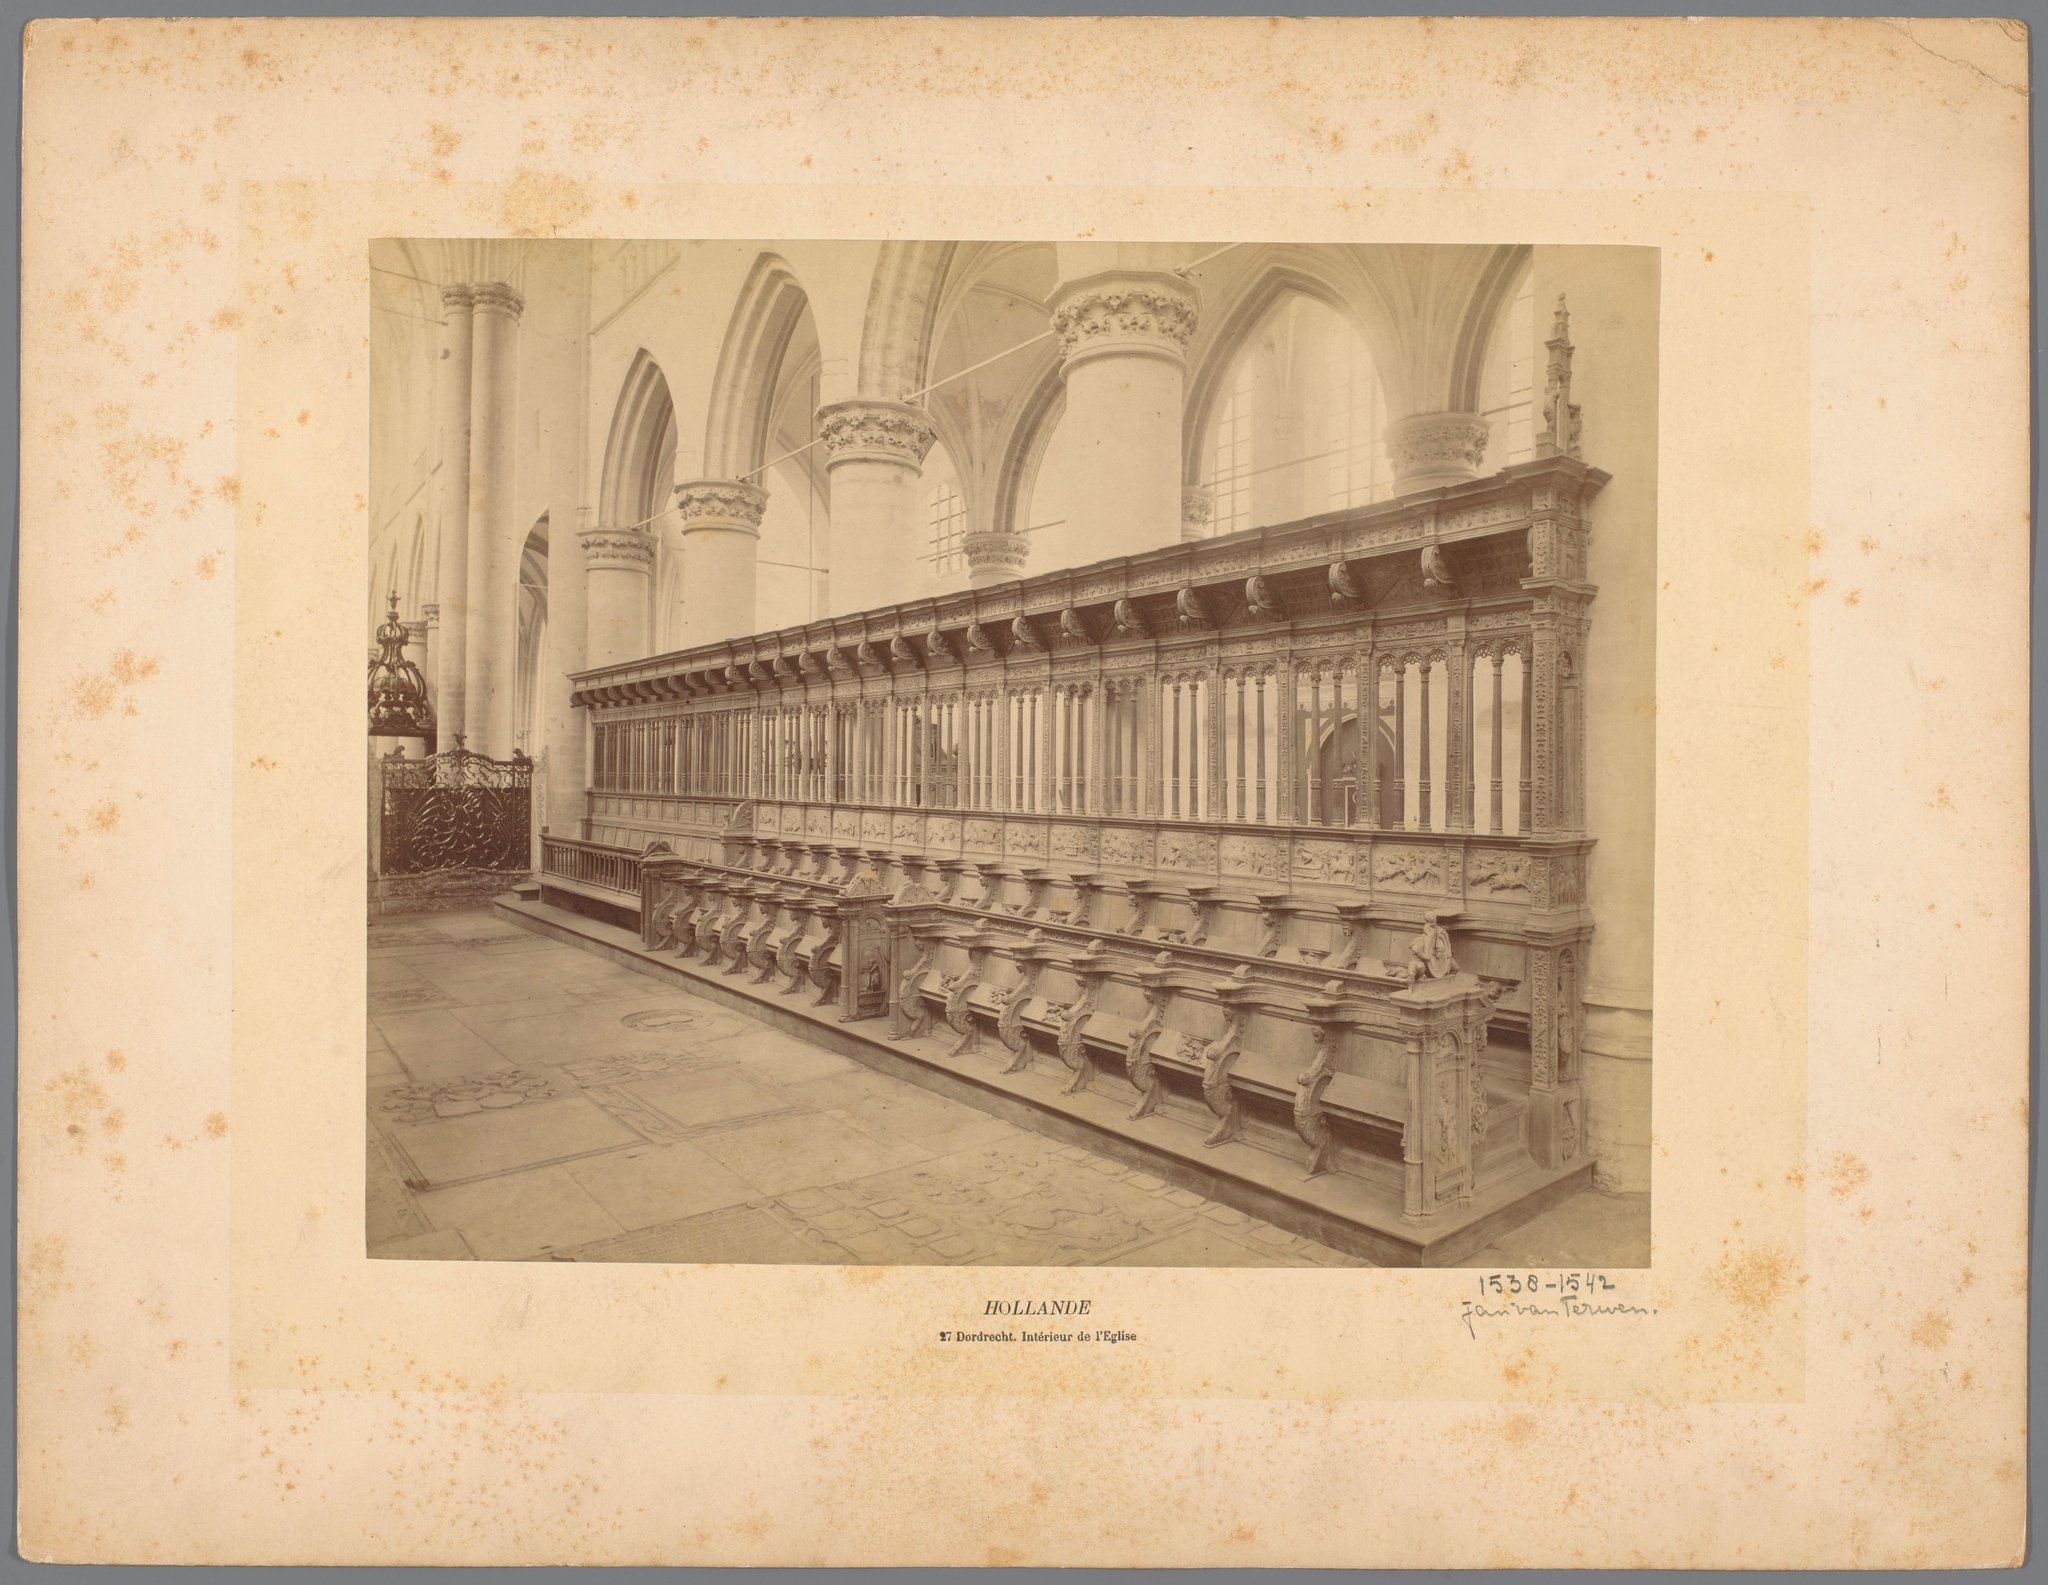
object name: photograph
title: Koorbanken in de Grote Kerk te Dordrecht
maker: Anonymous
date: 1875-1900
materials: cardboard, photographic support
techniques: albumen print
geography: grote of onze-lieve-vrouwekerk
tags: interior of church, seats of the clergy, choir-stalls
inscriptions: inscription: ‘1538-1542 Jan van Terwen.’, inscription: ‘HOLLANDE Dordrecht. Intérieur de l'Eglise’, number: ‘27’, collector's mark: Lugt 3937